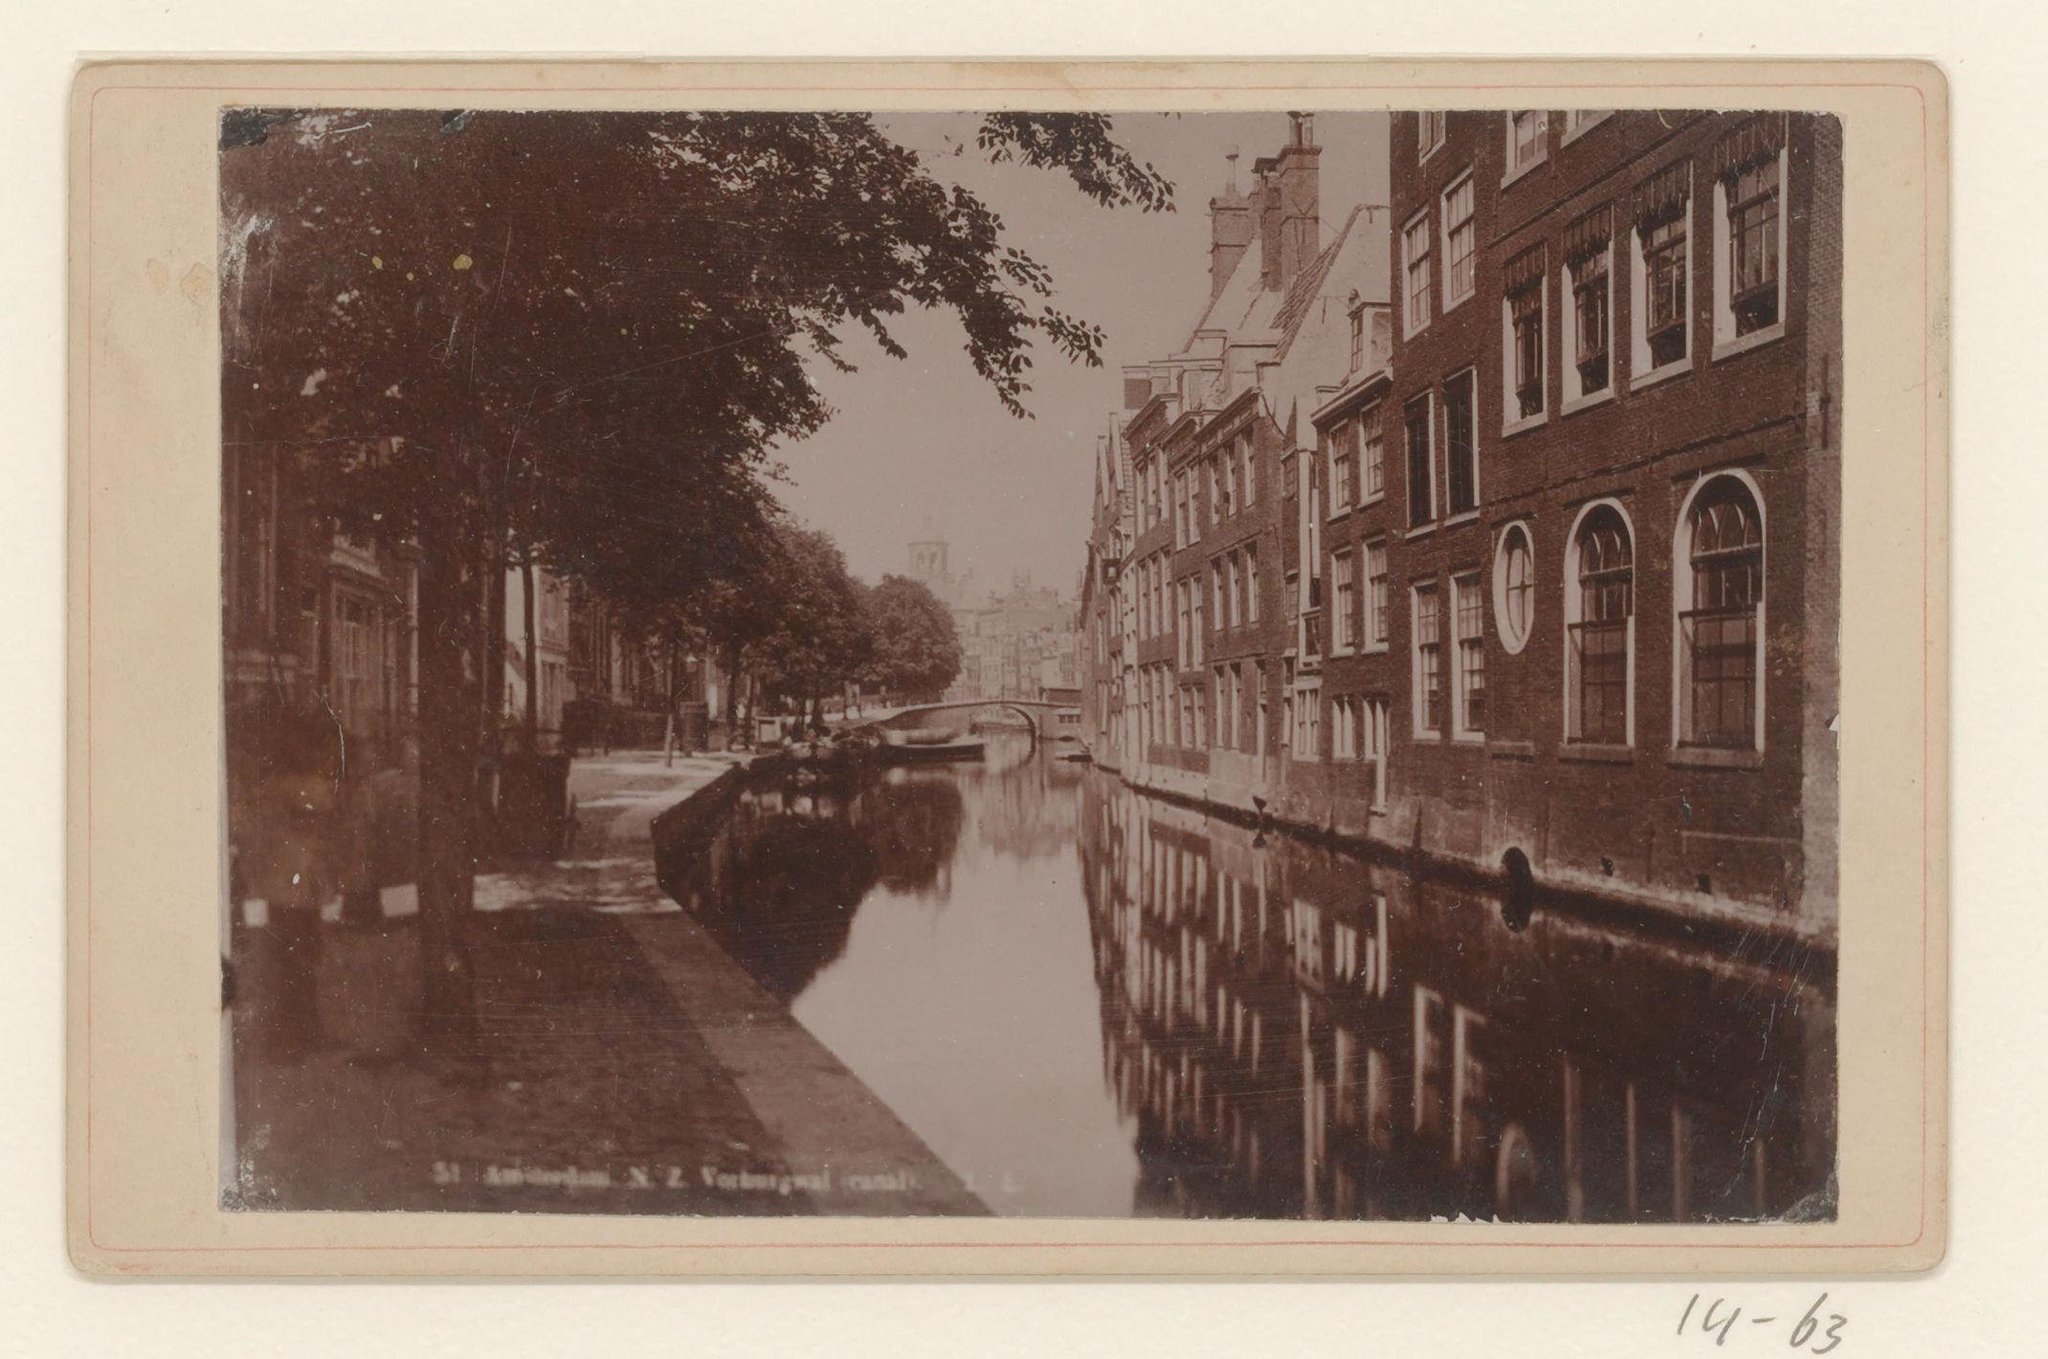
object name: cabinet photograph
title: Gezicht op de Nieuwezijds Voorburgwal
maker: Anonymous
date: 1875-1884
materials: paper, cardboard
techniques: collodion silver print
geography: amsterdam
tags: city-view in general; 'veduta', canal, street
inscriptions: inscription: ‘N.Z. Voorburgwal v/d demping. / 101.’, collector's mark: ‘14.63’ Lugt 1641b, stamp: ‘Gebr. Douwes / Atelier / Grimburgwal 15 / Amsterdam.’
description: Onderwerpsrubriek binnen de Atlas Amsterdam: Verhulststraat (Johannes), Viaducten, Vierwindenstraat, Vinkenbuurt, Vinkenpad, Vinkenstraat, Vischsteeg, Vliegendesteeg, Voetboogstraat, Volewijk, Vondelstraat, Voorburgwal (N.Z.).